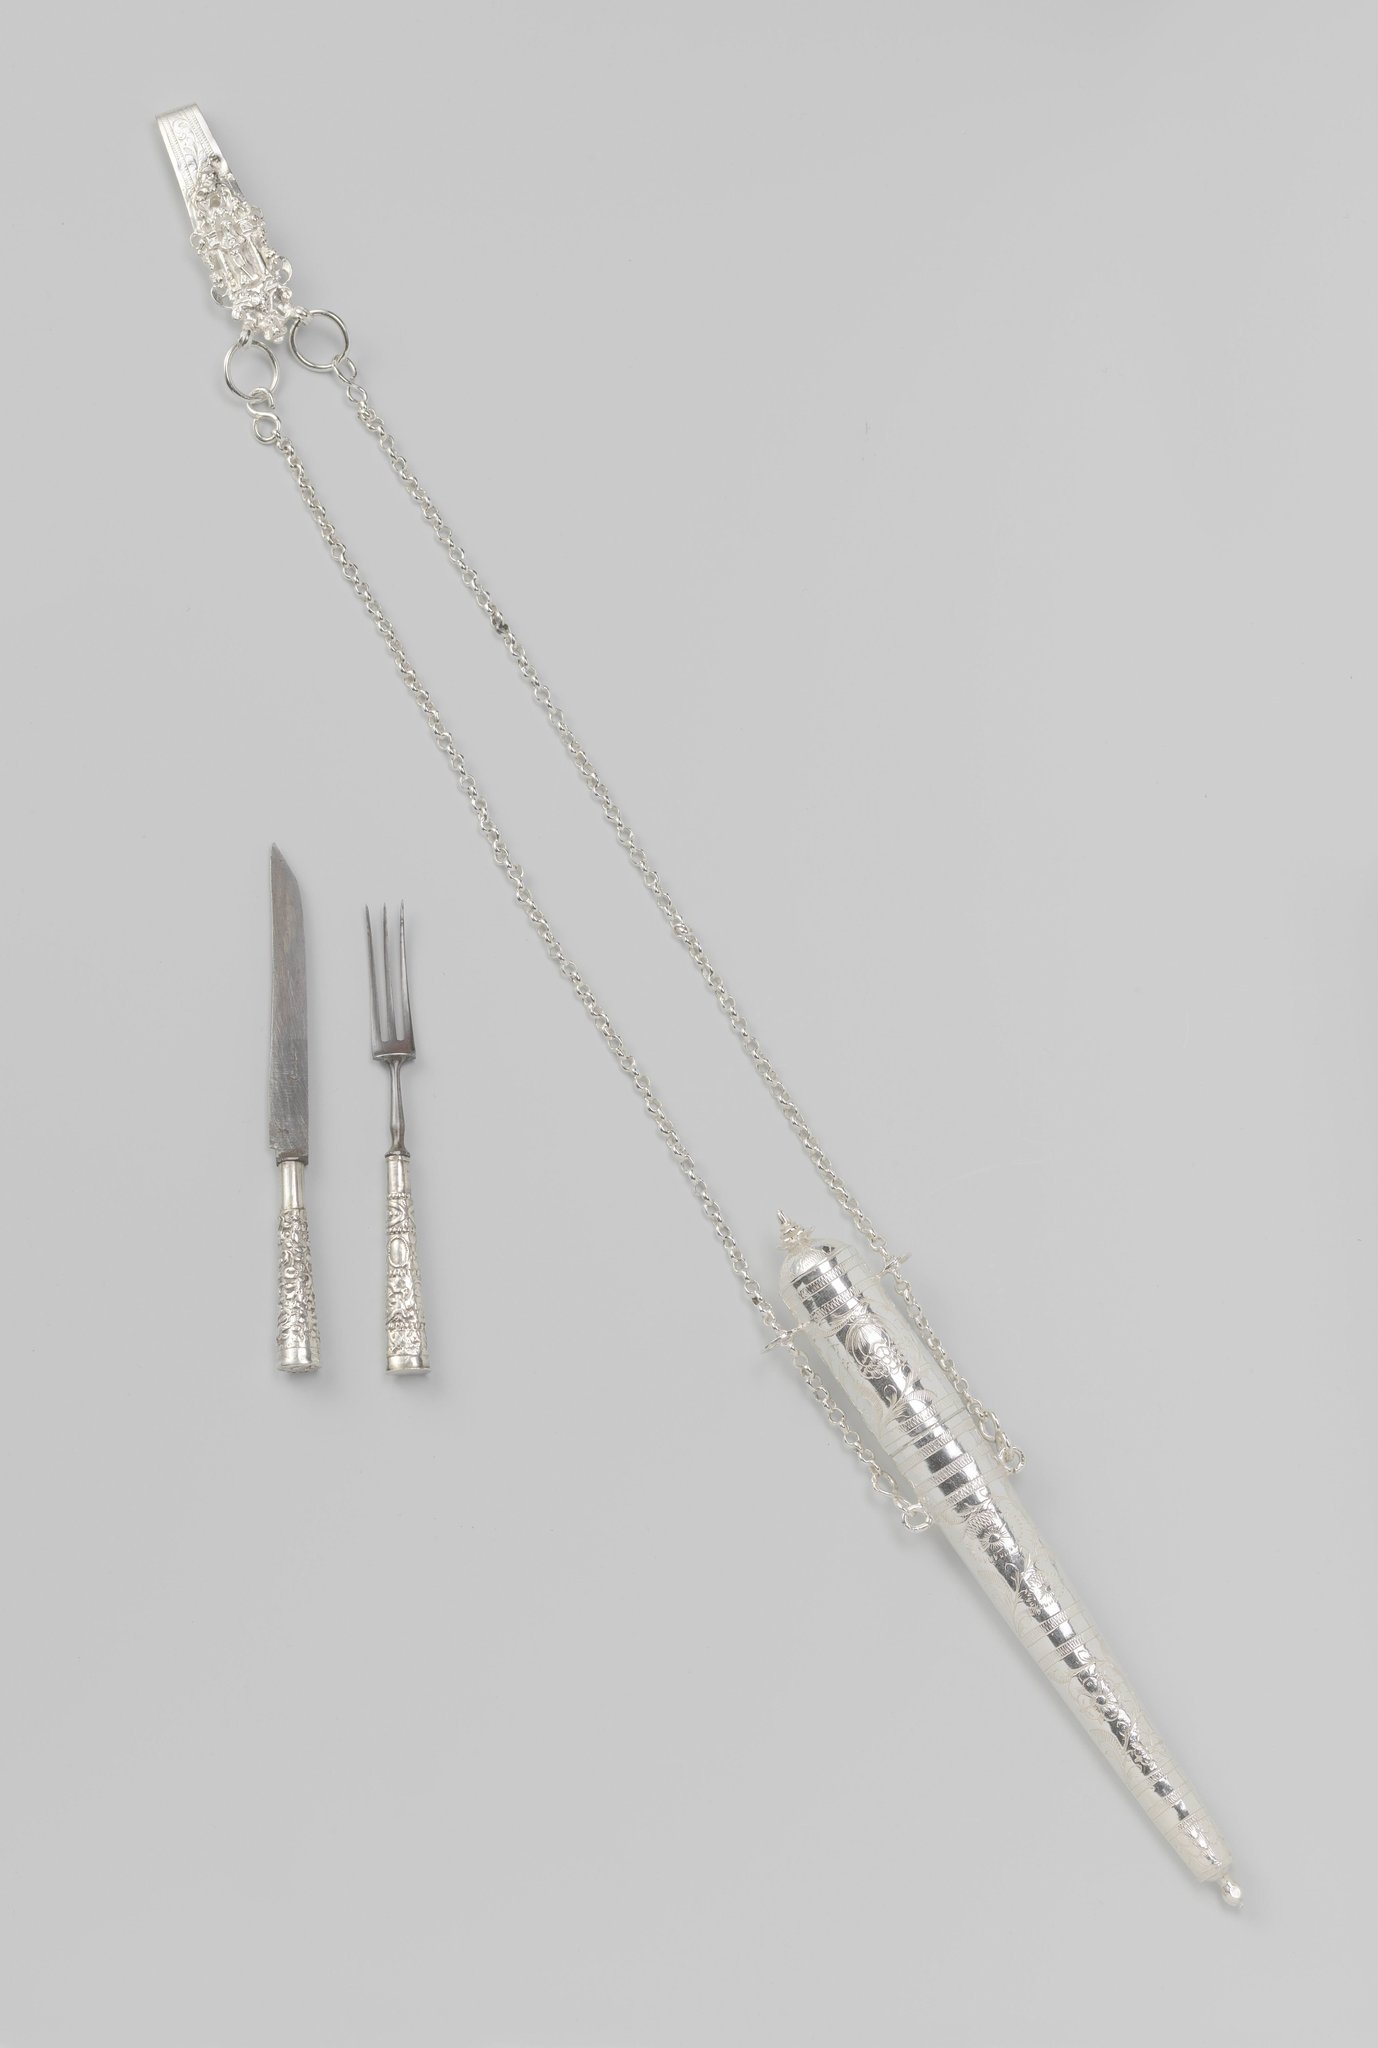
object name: case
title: Portable cutlery set on a chatelaine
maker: Anonymous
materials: silver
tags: flowers ~ ornament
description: Mes en vork met heft van zilver. Koker deksel, zilver, met gegraveerde bloemranken. Met ketting aan een châtelaine (B) bevestigd.